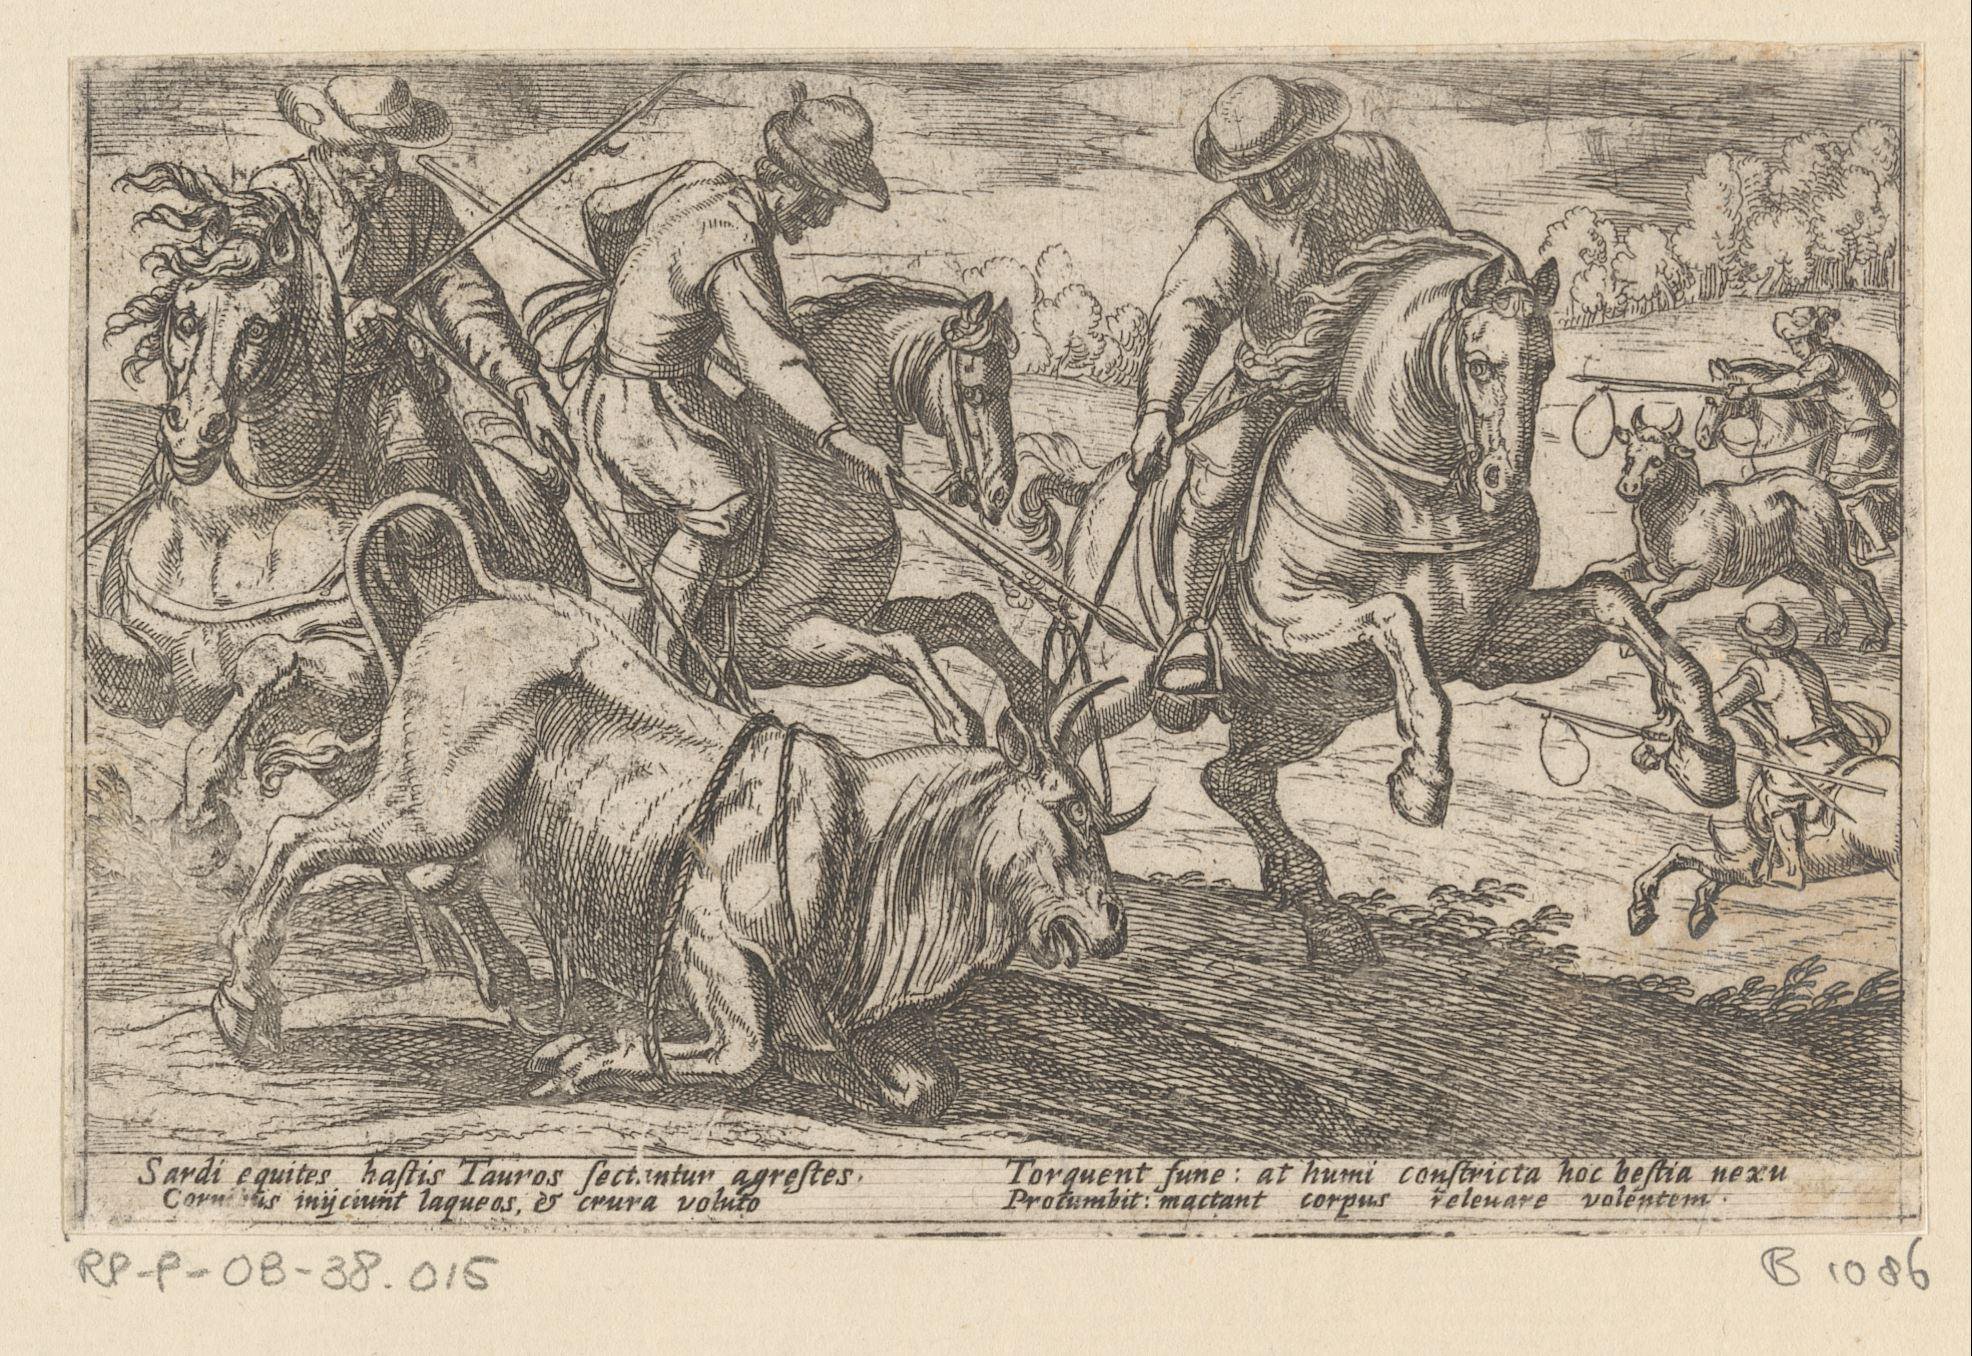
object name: print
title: Diverse jacht- en strijdscènes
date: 1602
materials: paper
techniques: etching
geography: italy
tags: hunter, hunters hunting (n.b.: in 1988-1990 this notation denoted the concept of 43c11421 'hunters resting during the hunt'), ox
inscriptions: collector's mark: Lugt 240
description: Landschap met jagers te paard die wilde ossen vangen met behulp van speren en touwen. Tekst in het Latijn in ondermarge.